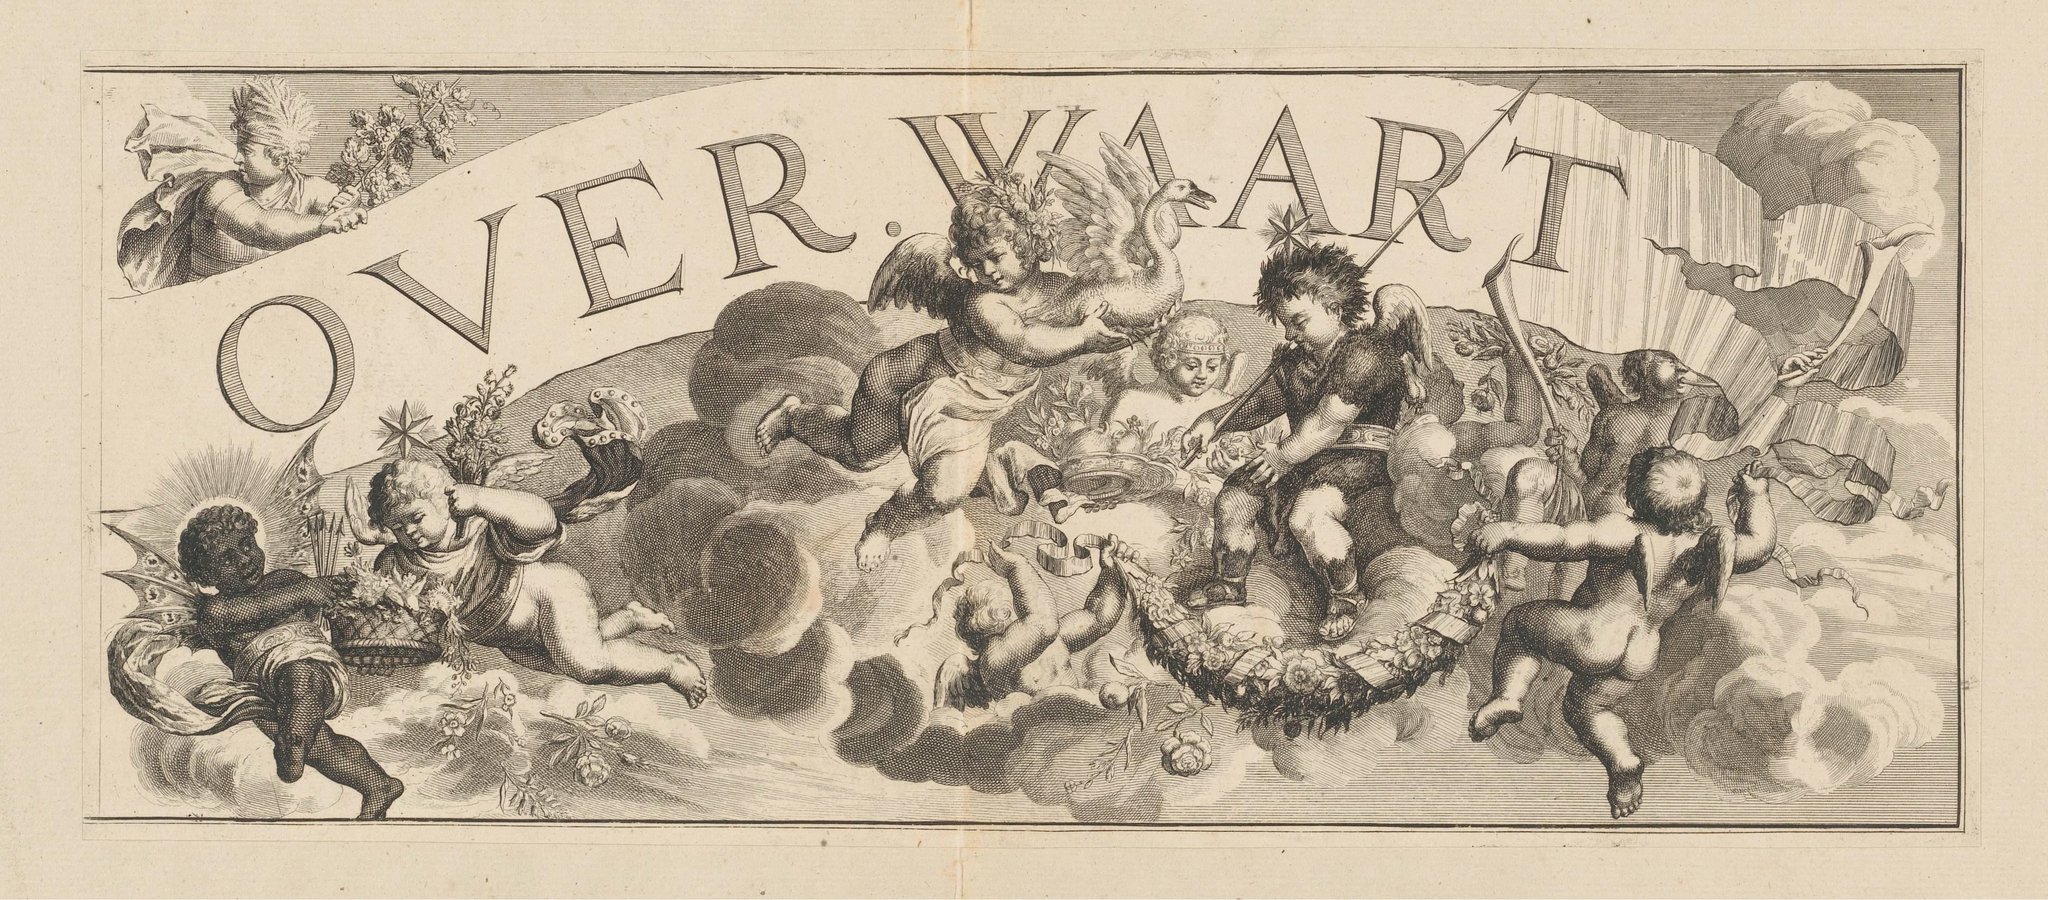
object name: print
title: Caarte van den Overwaart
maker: jan van vianen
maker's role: print maker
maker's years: 1660-1726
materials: paper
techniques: engraving, etching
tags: cupids: 'amores', 'amoretti', 'putti'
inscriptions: collector's mark: Lugt 195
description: Zie RP-P-AO-14-13 voor een proefdruk van de bijhorende kaart. In de collectie Atlas Ottens zijn slechts dit en nog één ander blad (RP-P-AO-14-13-5) van de sierrand te vinden. De sierrand bestond naast deze twee bladen met de titel 'Caarte van den Overwaart' uit allegorische voorstellingen en de wapens van de bestuursleden van het waterschap.